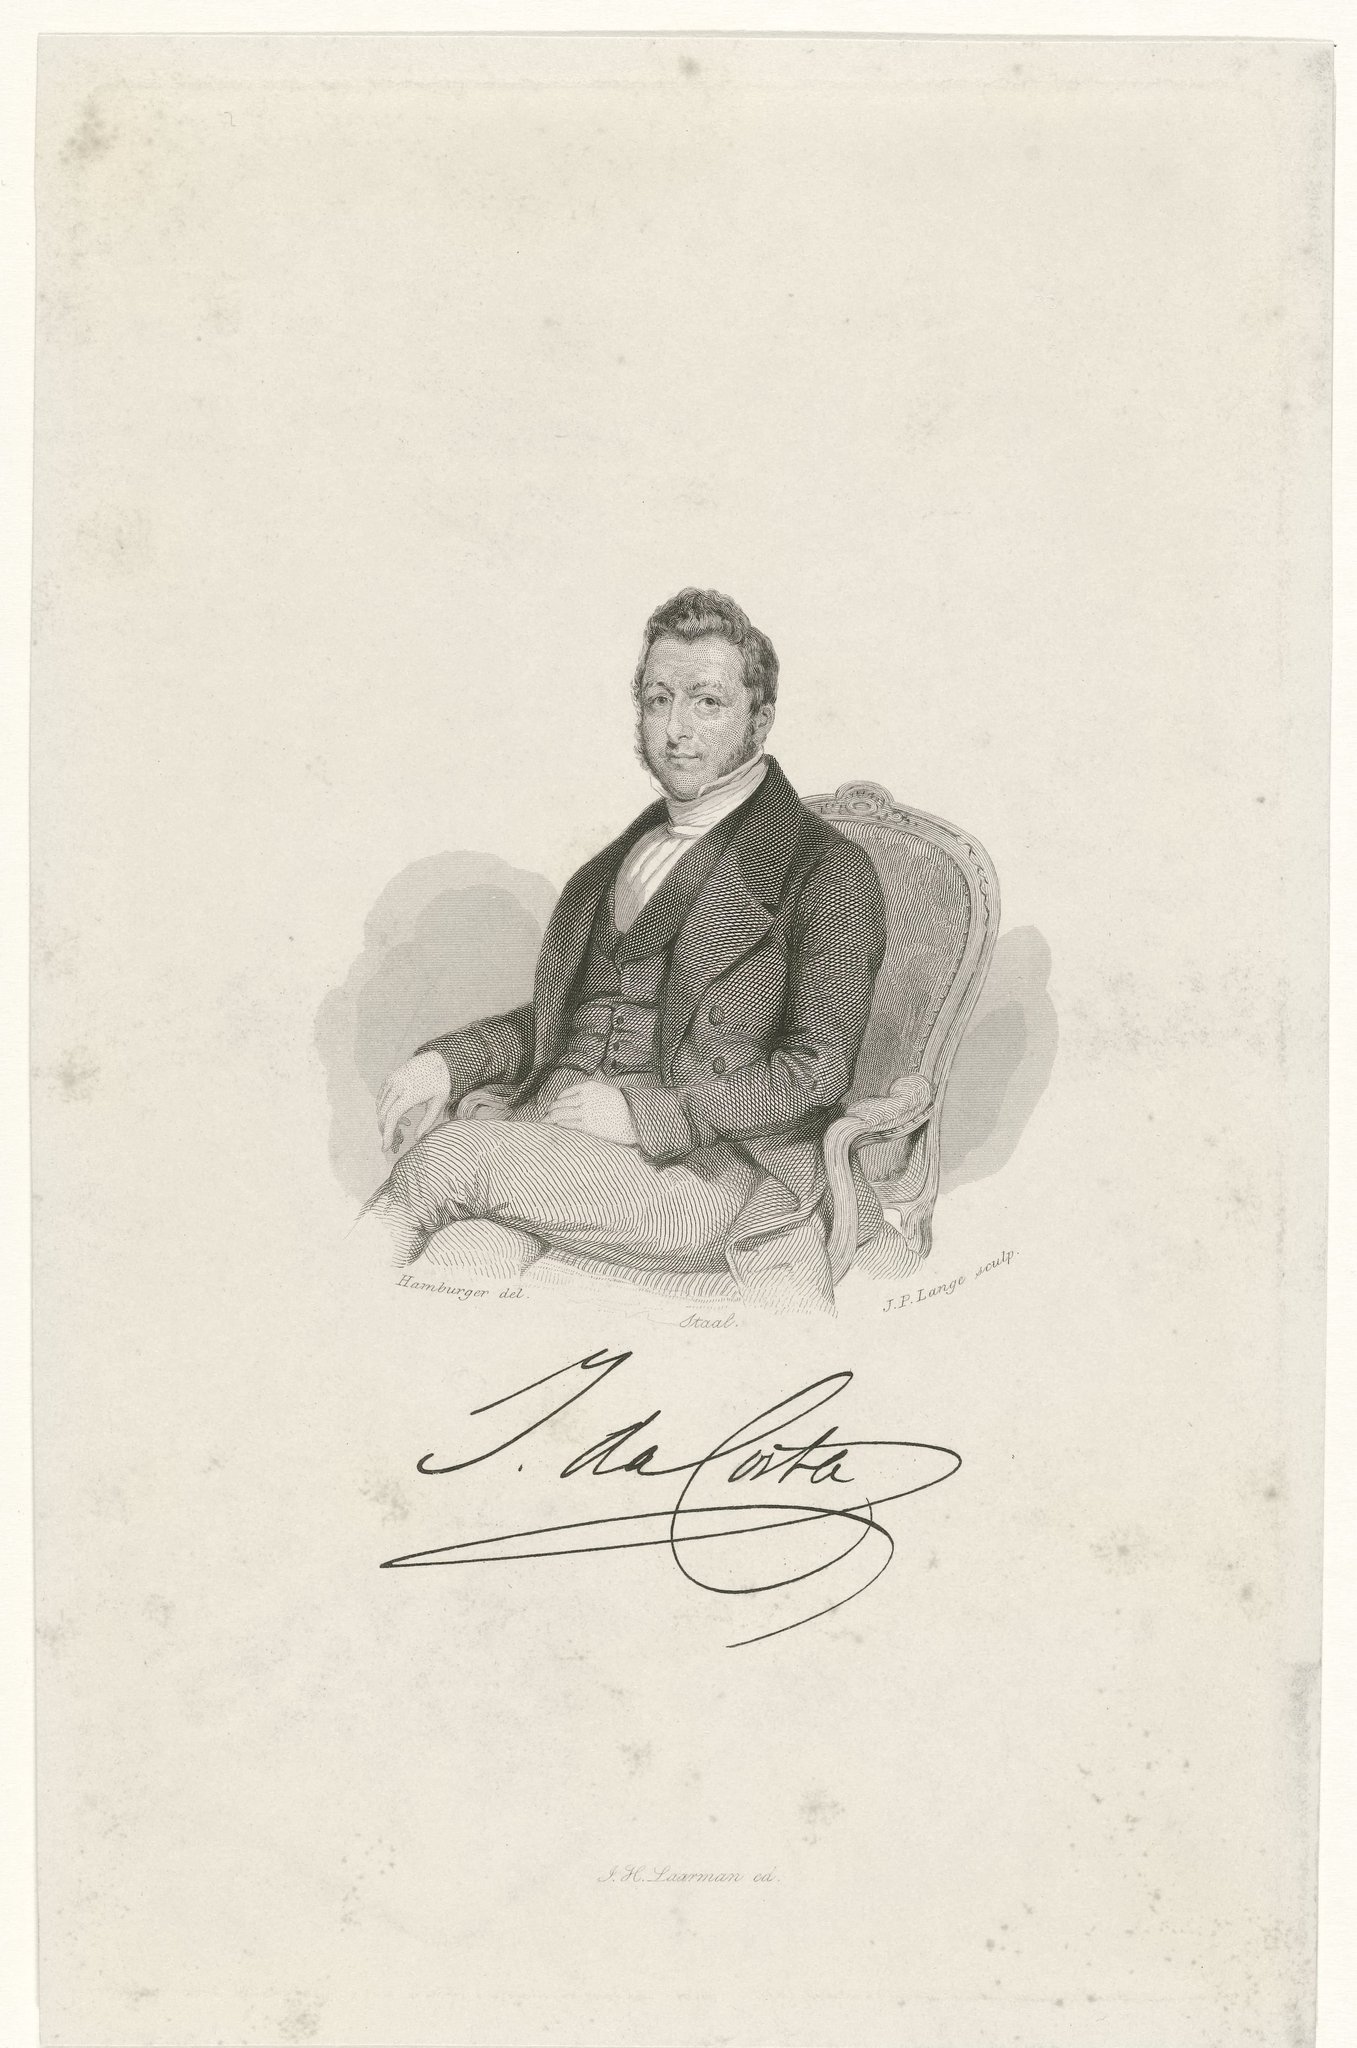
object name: print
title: I. Da Costa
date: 1820-1849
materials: paper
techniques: engraving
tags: heusden, generaal, gijsbertus martinus cort heijligers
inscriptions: collector's mark: Lugt 2228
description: Portret van Isaac da Costa, dichter en prozaschrijver, blootshoofds. Kniestuk, zittend in een stoel naar links gedraaid.